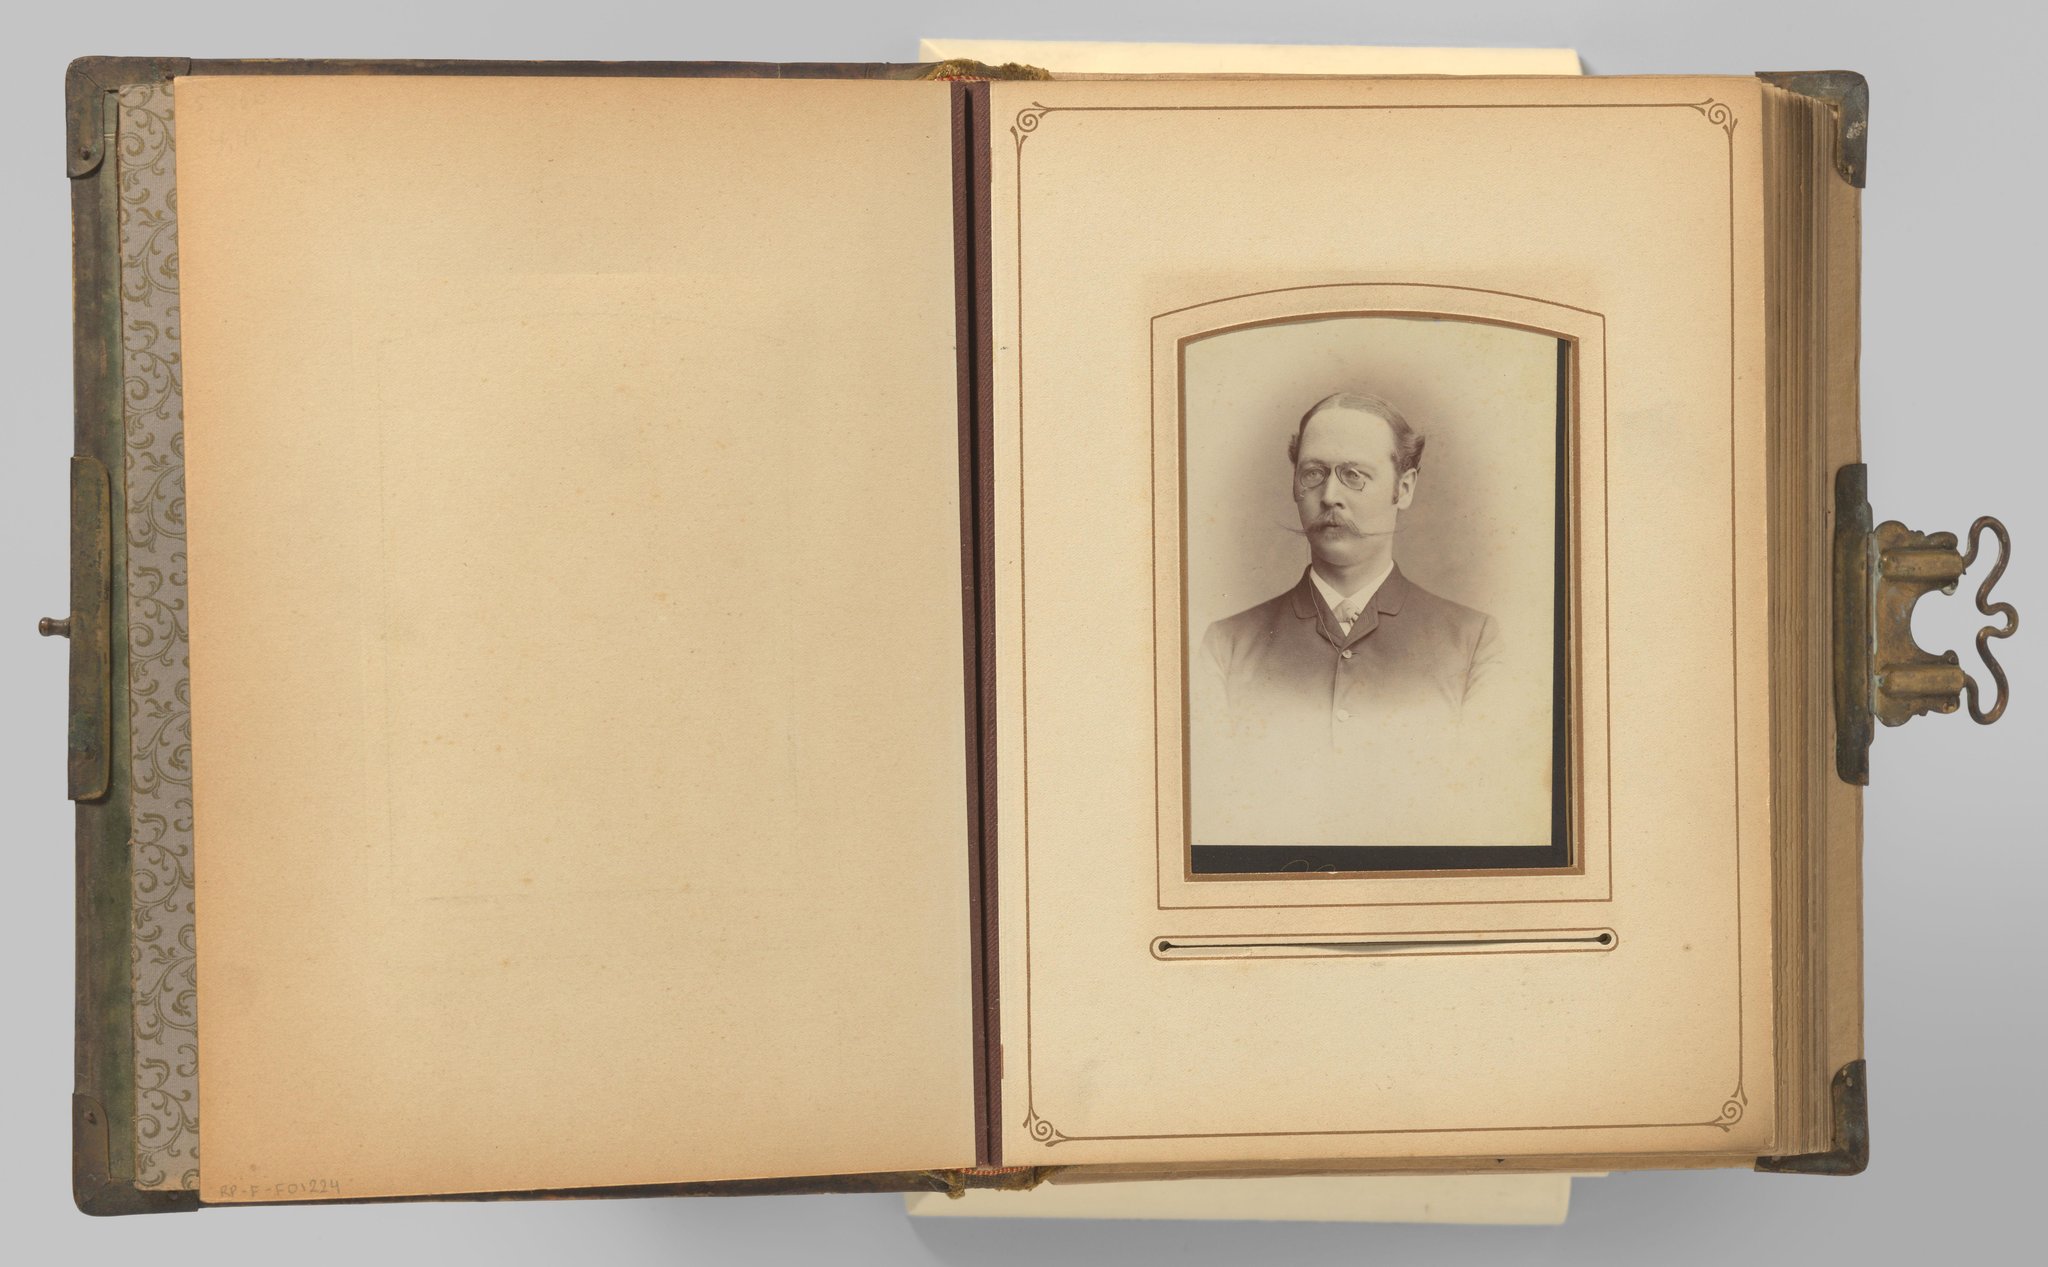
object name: cabinet photograph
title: Portret van een man met snor en bril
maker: rudolf bradengeier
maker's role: fotograaf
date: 1860-1900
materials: cardboard, photographic support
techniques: albumen print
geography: dusseldorf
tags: eyeglasses, spectacles, moustache, historical persons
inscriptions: inscription: ‘Atelier/ Bradengeier/ Düsseldorf/ Elberfelder-Str. 4’